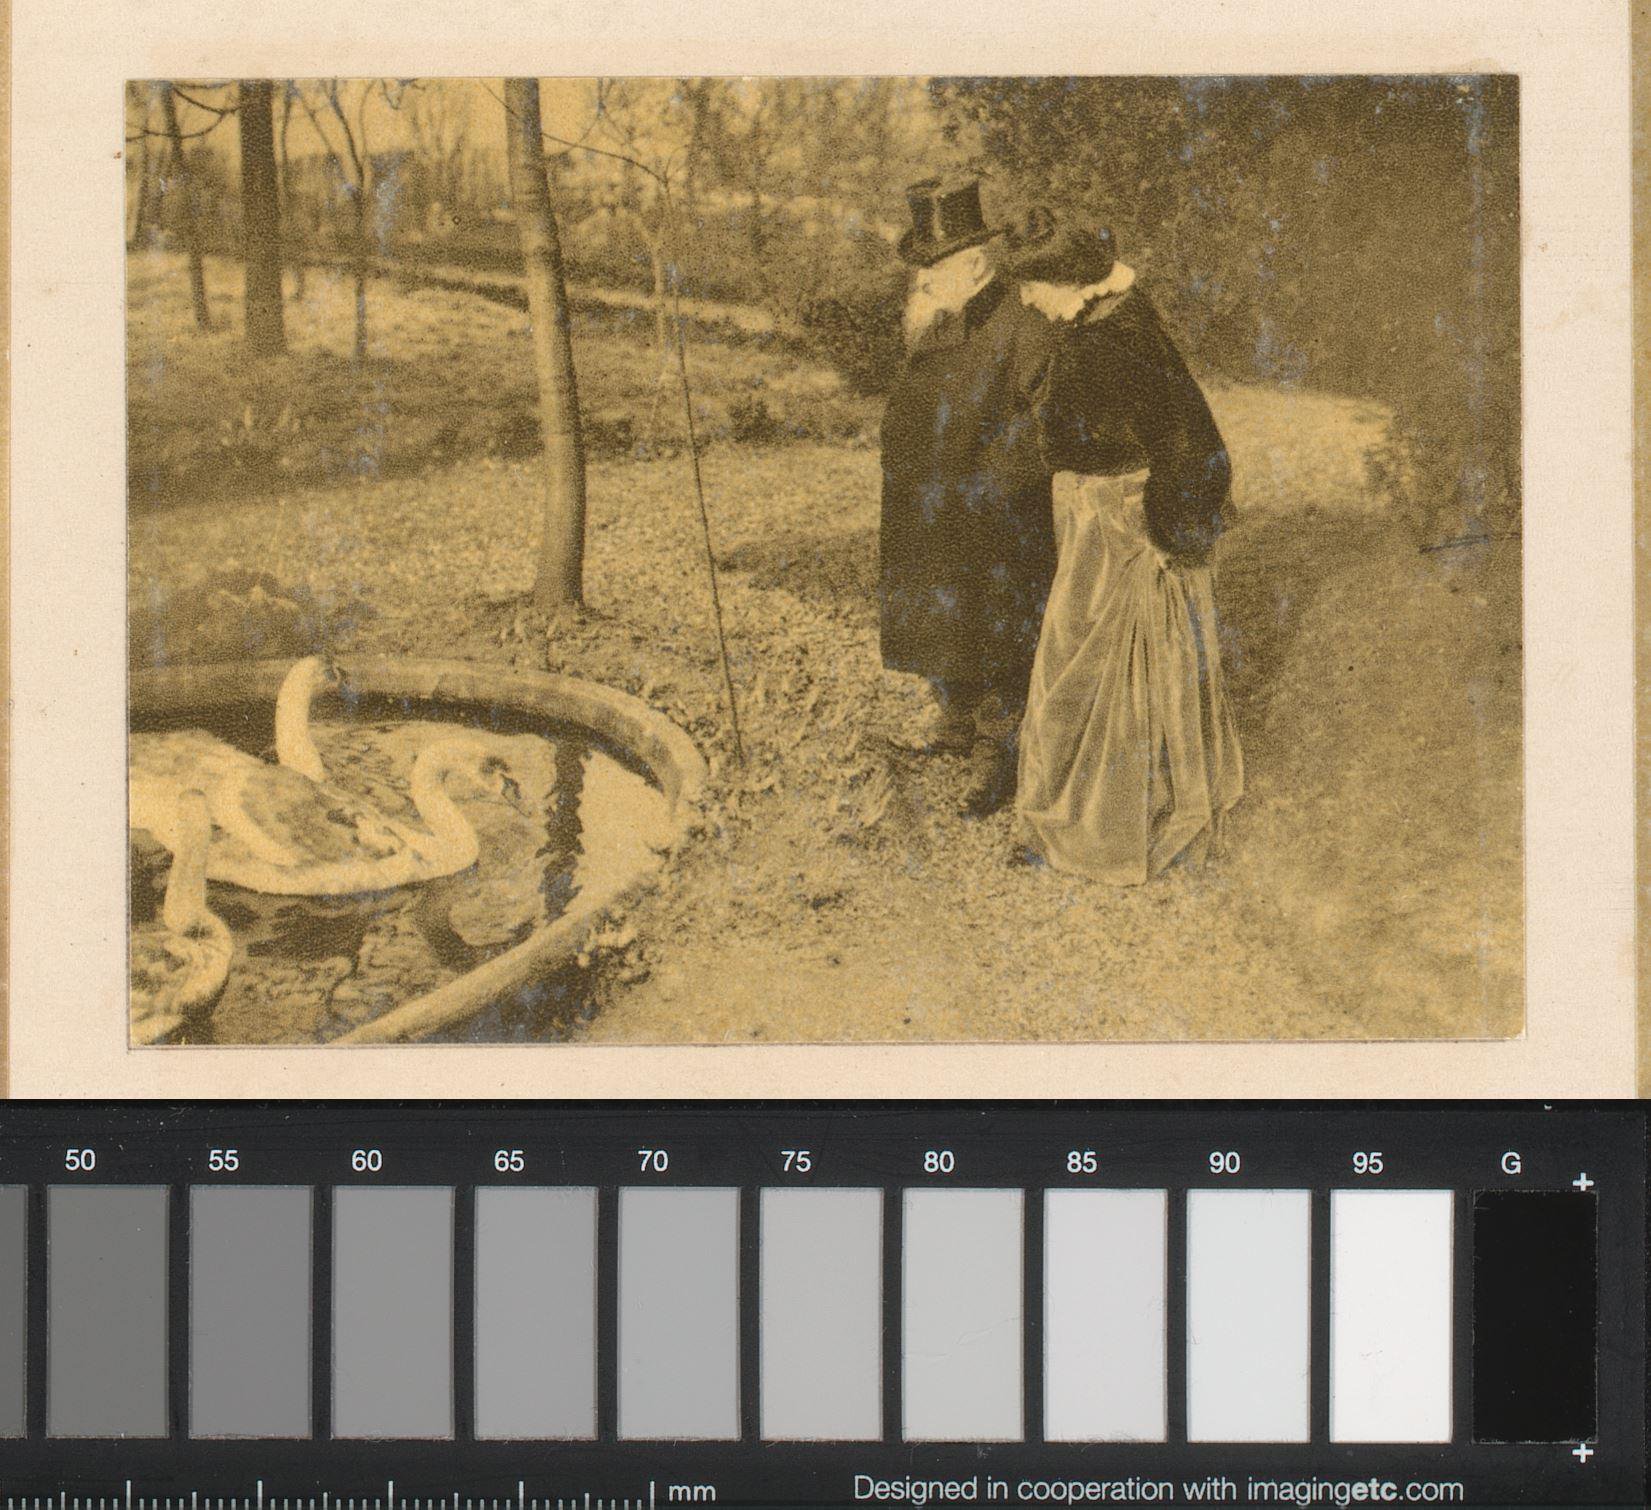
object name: photograph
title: Auguste Rodin met een vrouw bij een vijver met zwanen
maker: Anonymous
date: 1895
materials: paper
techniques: rotogravure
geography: france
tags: paris, print maker, draughtsman, auguste rodin, artist (in general), france